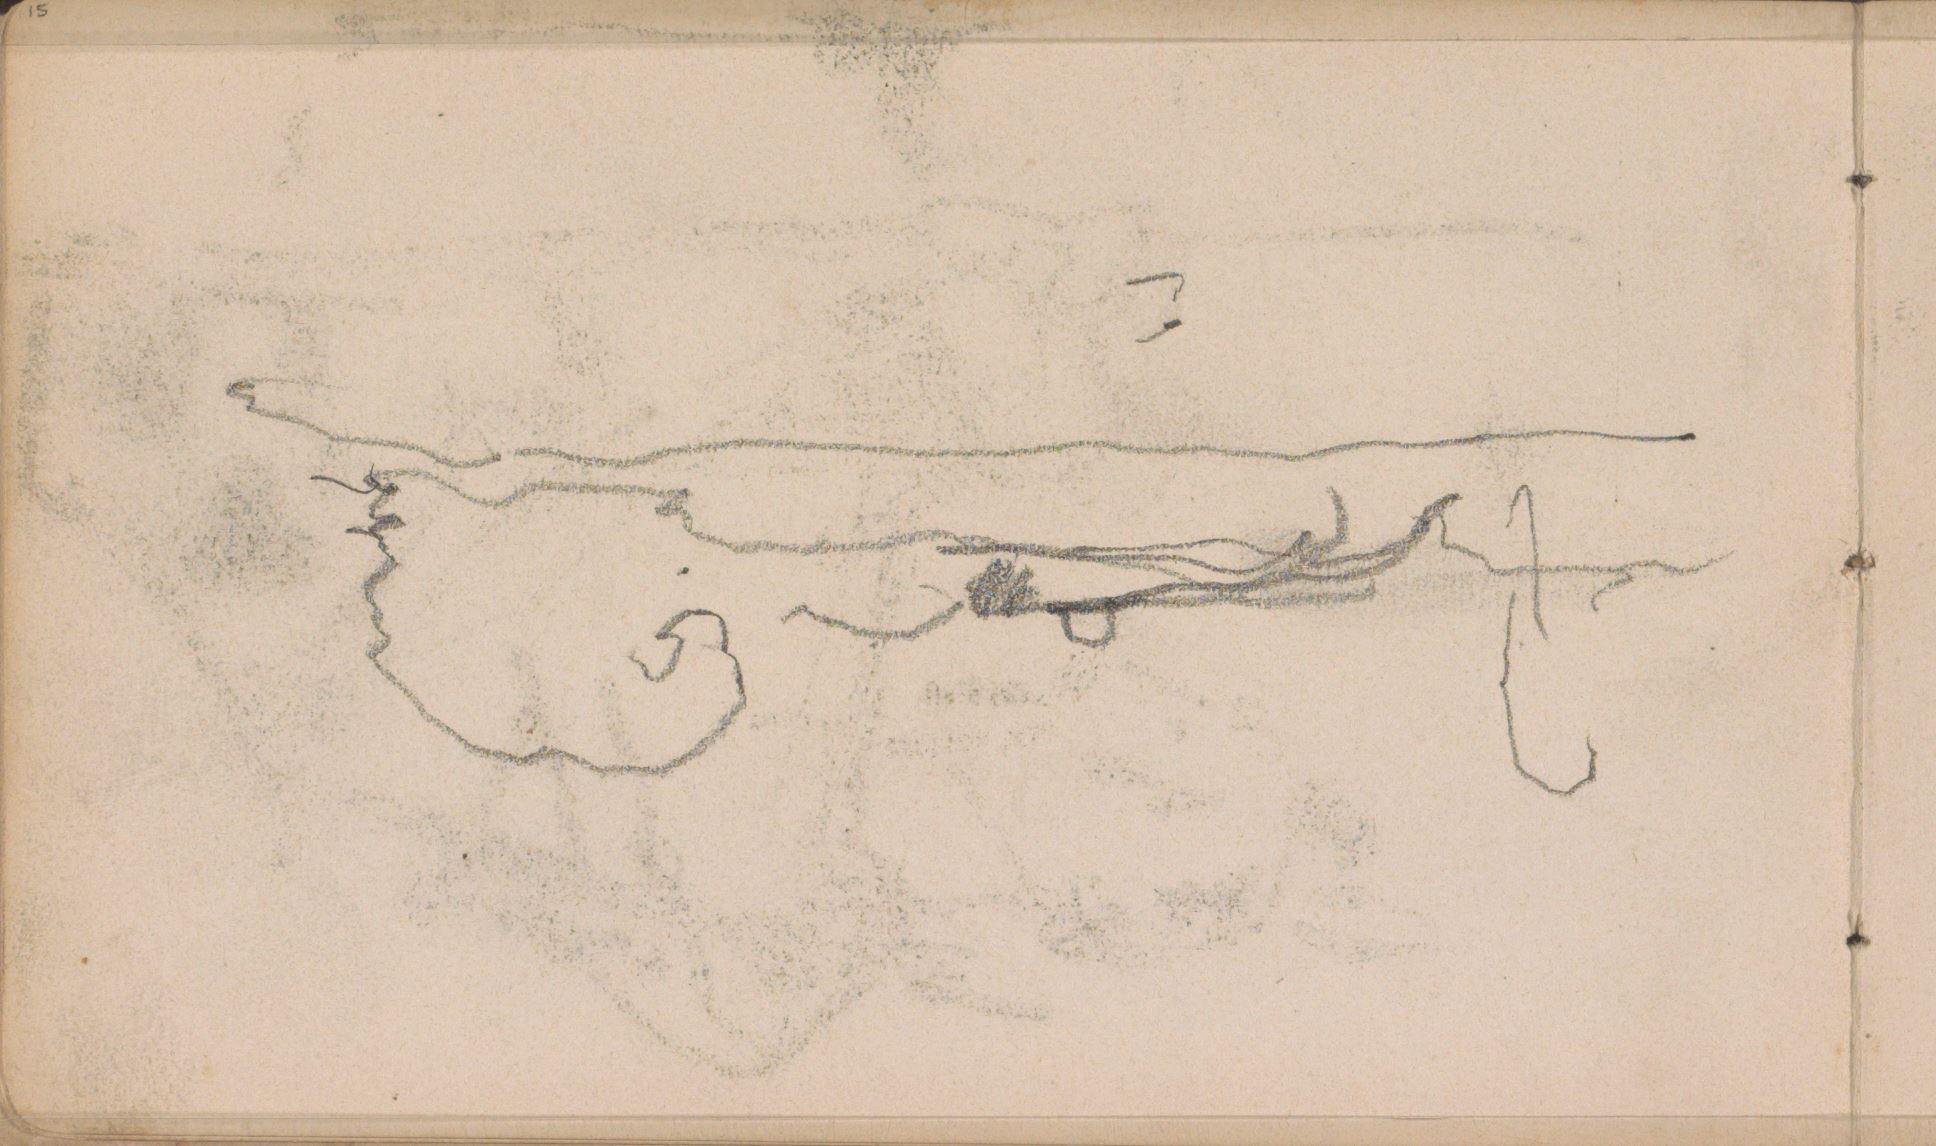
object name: sketchbook leaf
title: Landschap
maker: george hendrik breitner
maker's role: draughtsman, painter, print maker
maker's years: 1857-1923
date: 1881-1883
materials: paper, pencil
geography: north brabant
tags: landscapes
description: Pagina 15 uit een schetsboek met 42 bladen.